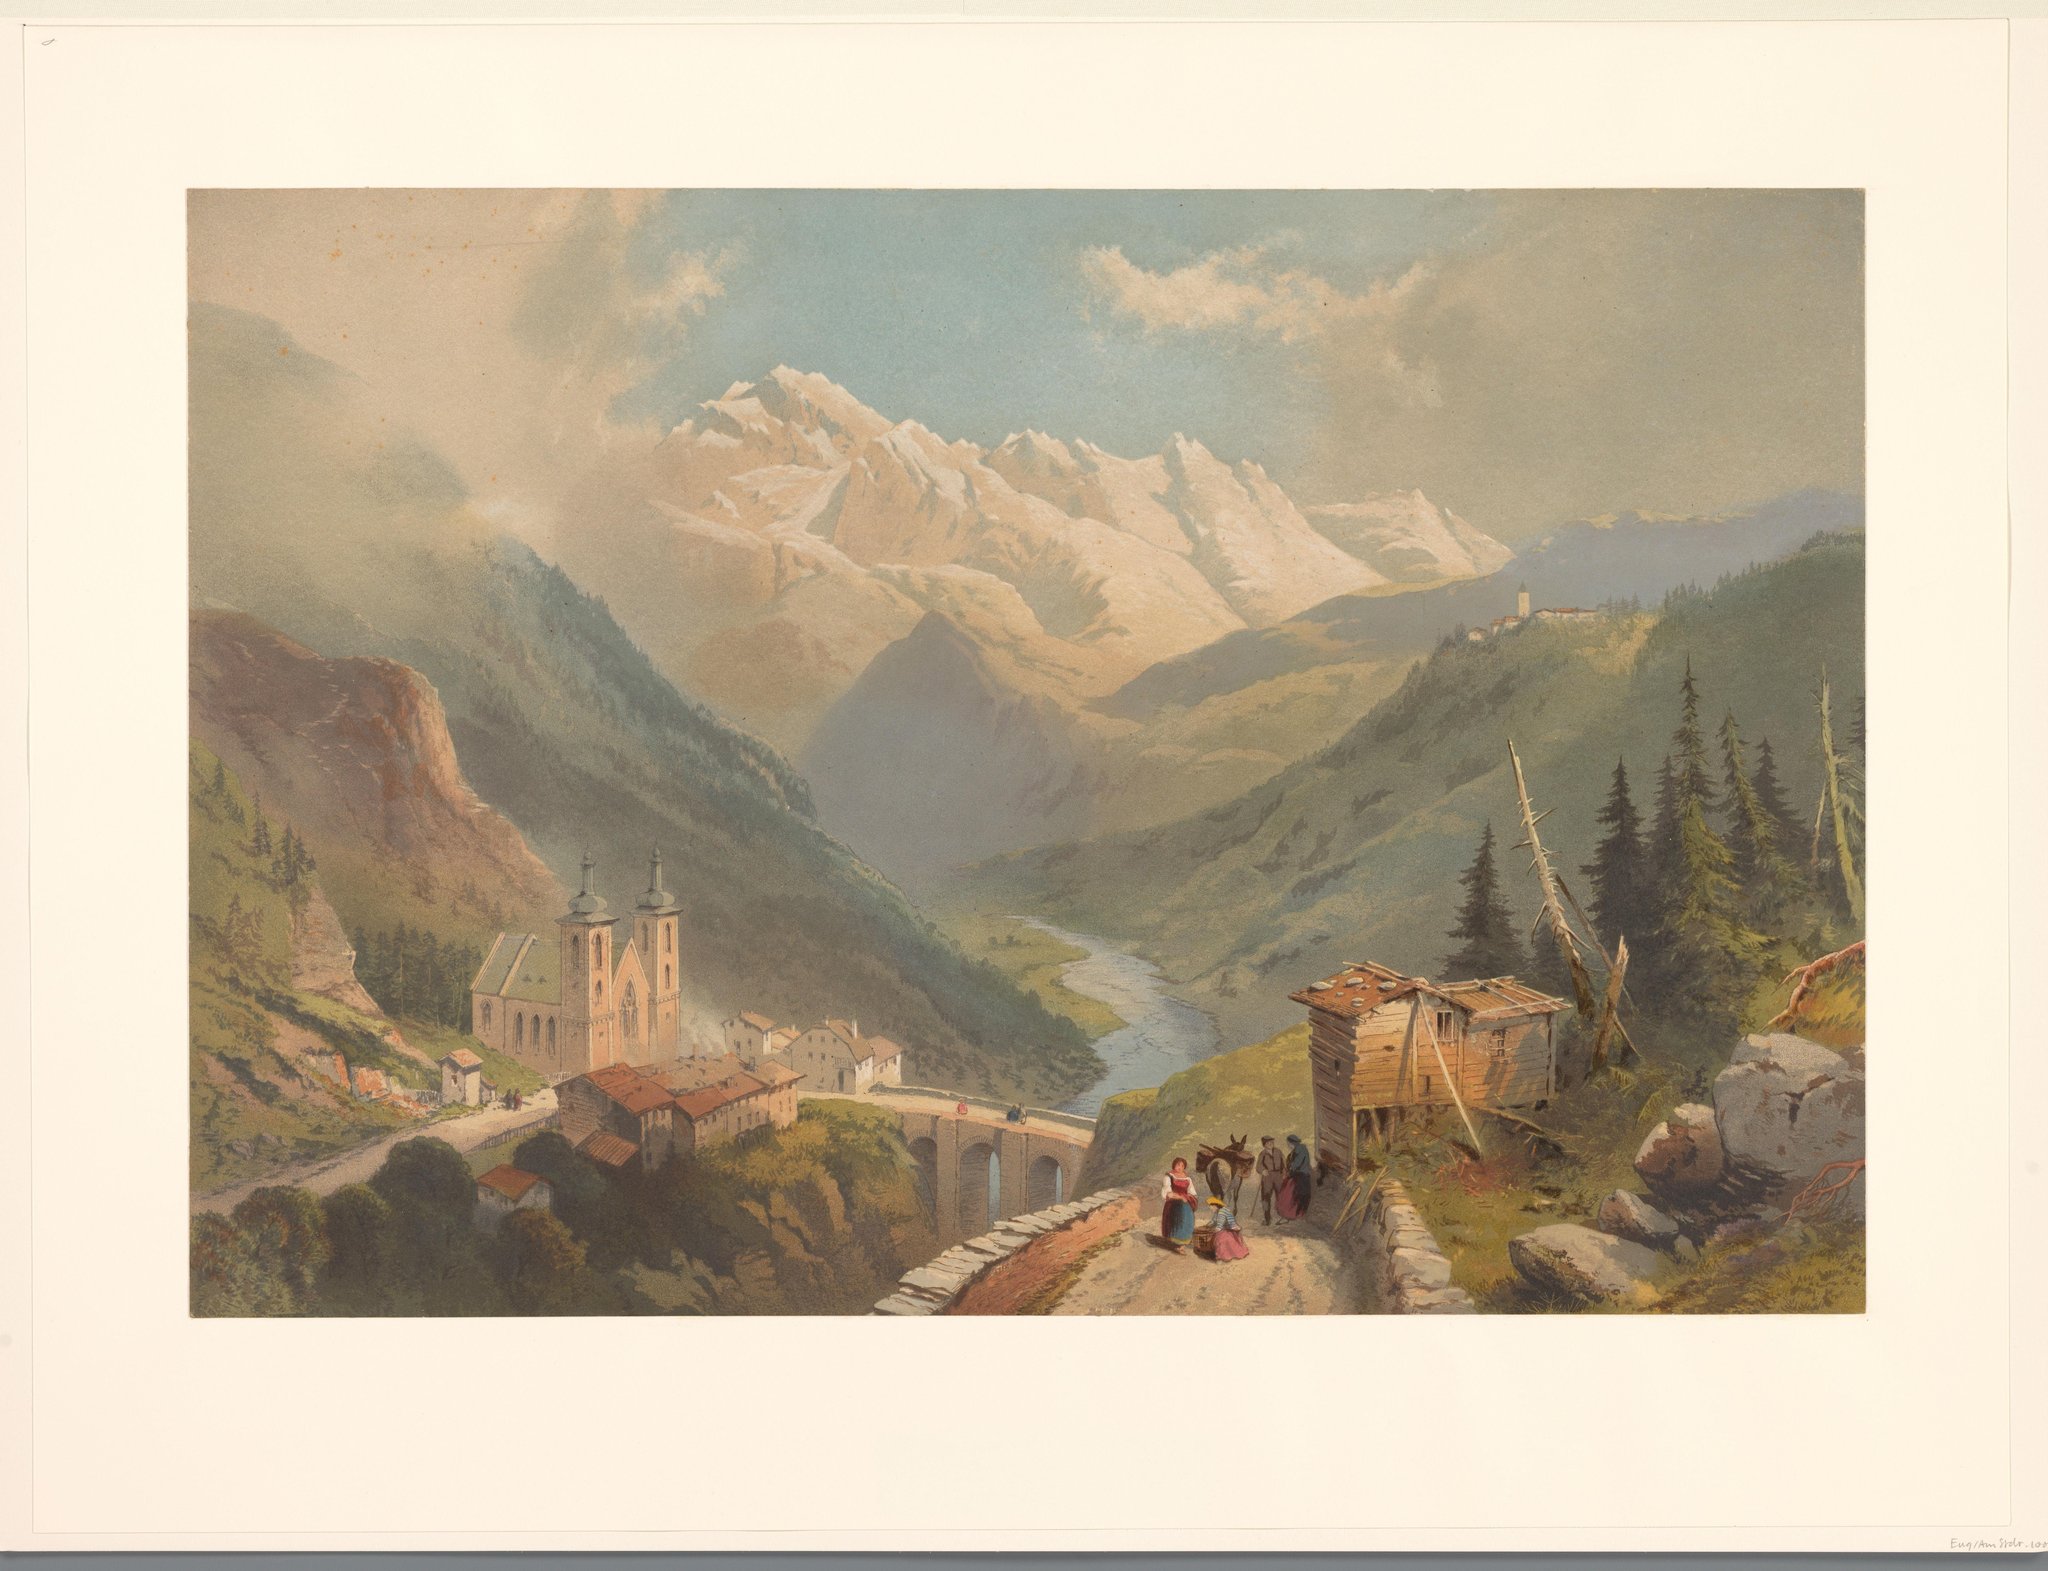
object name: print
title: Gezicht op de Brennerpas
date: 1839-1865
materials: paper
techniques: lithograph, hand coloring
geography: london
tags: mountains (+ landscape with figures, staffage), 'en route', traveller under way, bridge in village across river, canal, etc.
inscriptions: collector's mark: Lugt 2228